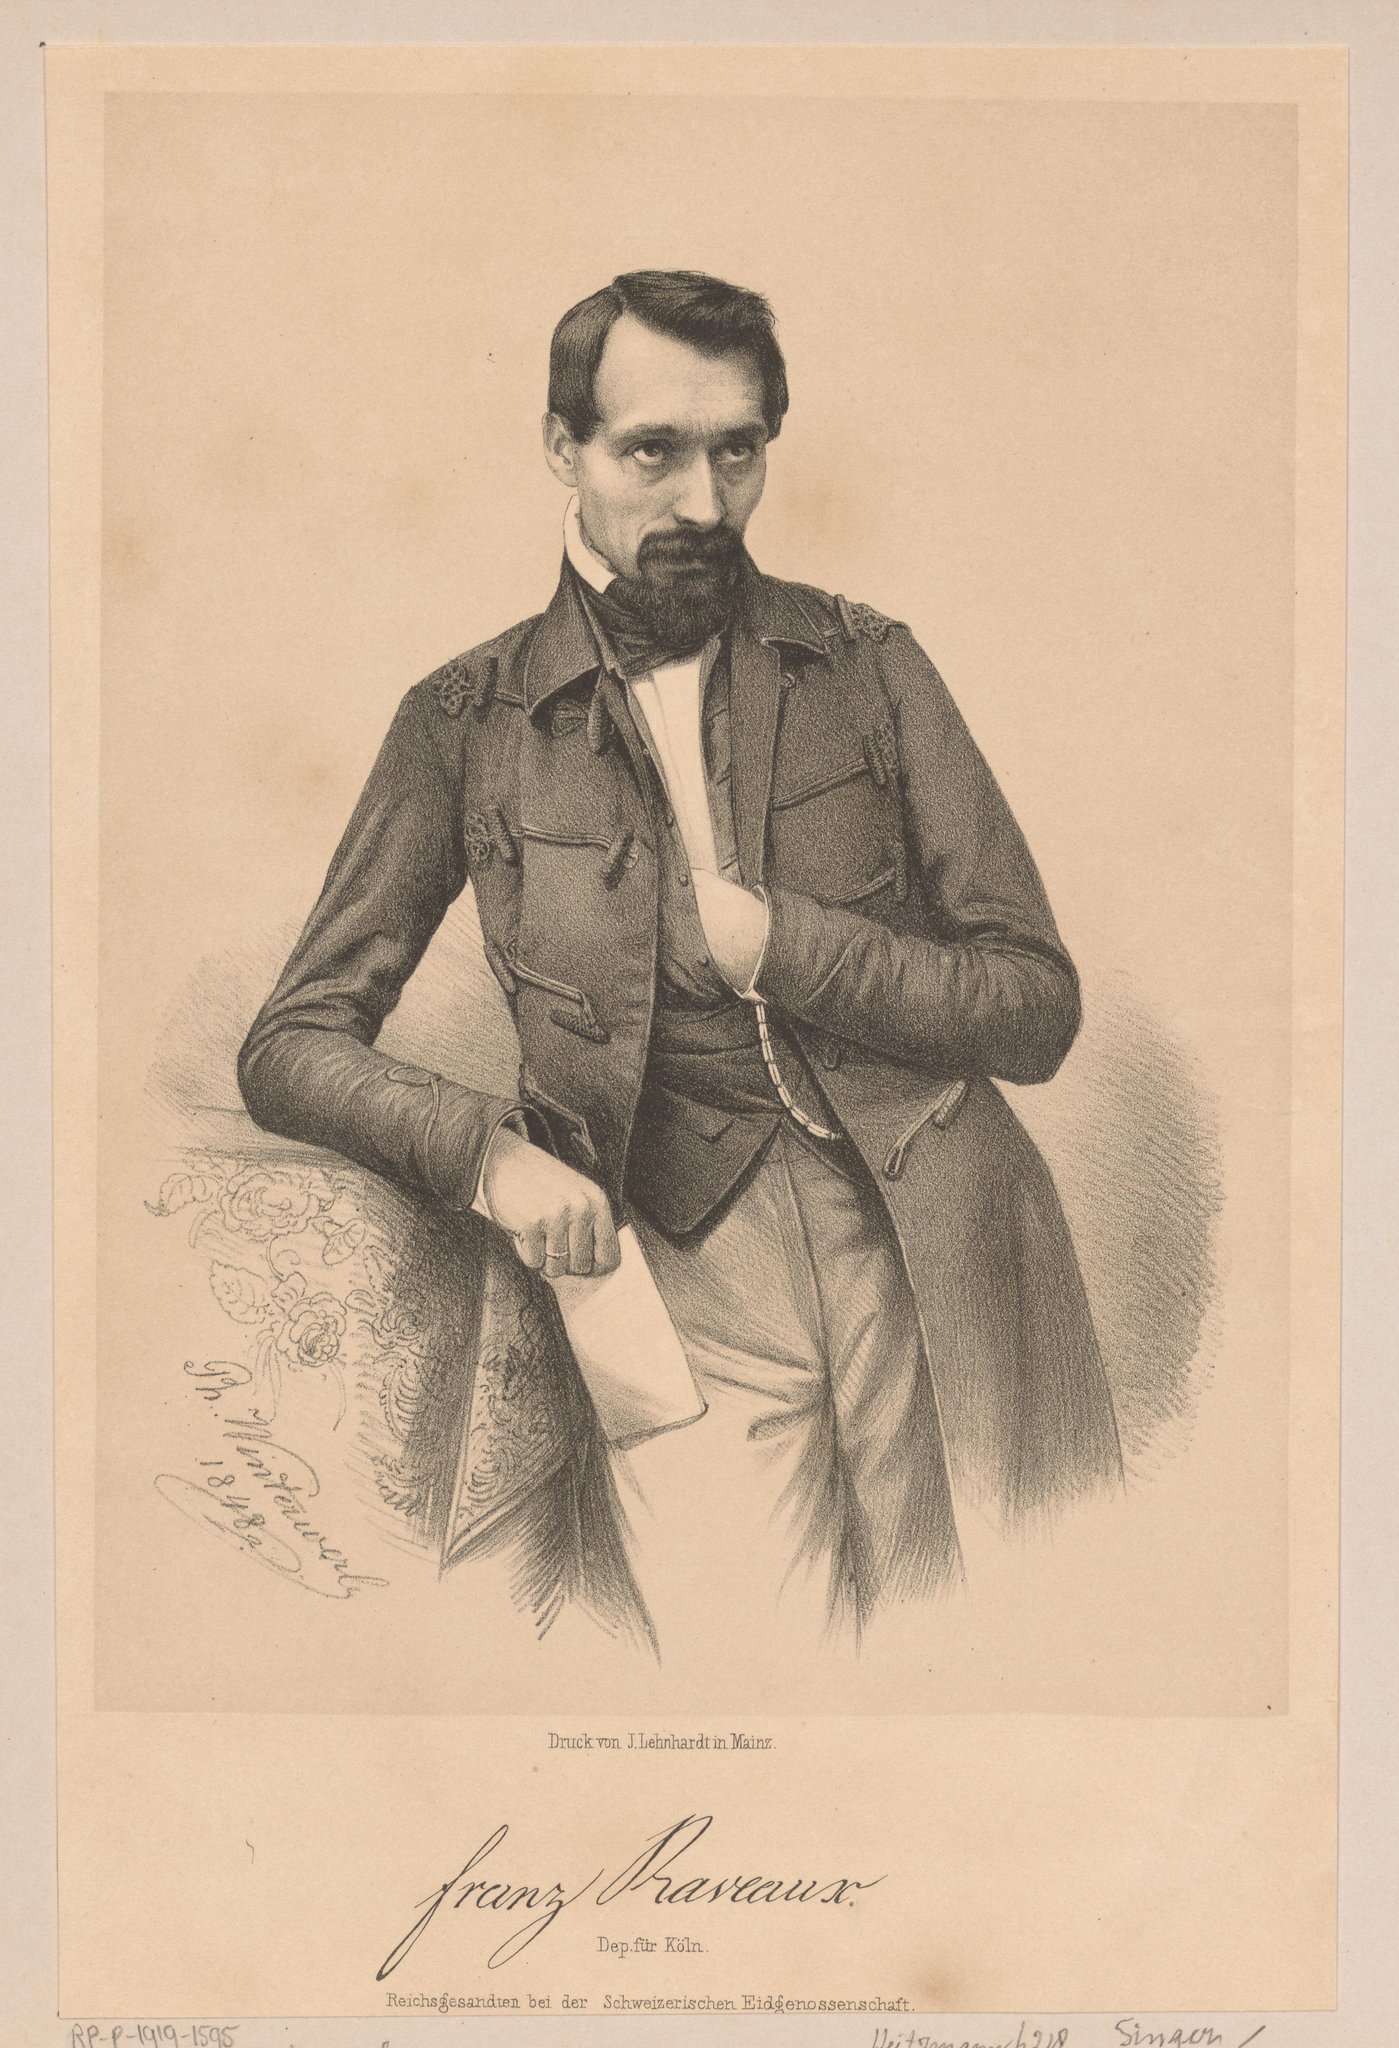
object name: print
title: Portret van Franz Raveaux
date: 1848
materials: paper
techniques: lithograph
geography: mainz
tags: politician, historical persons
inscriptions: collector's mark: Lugt 2228